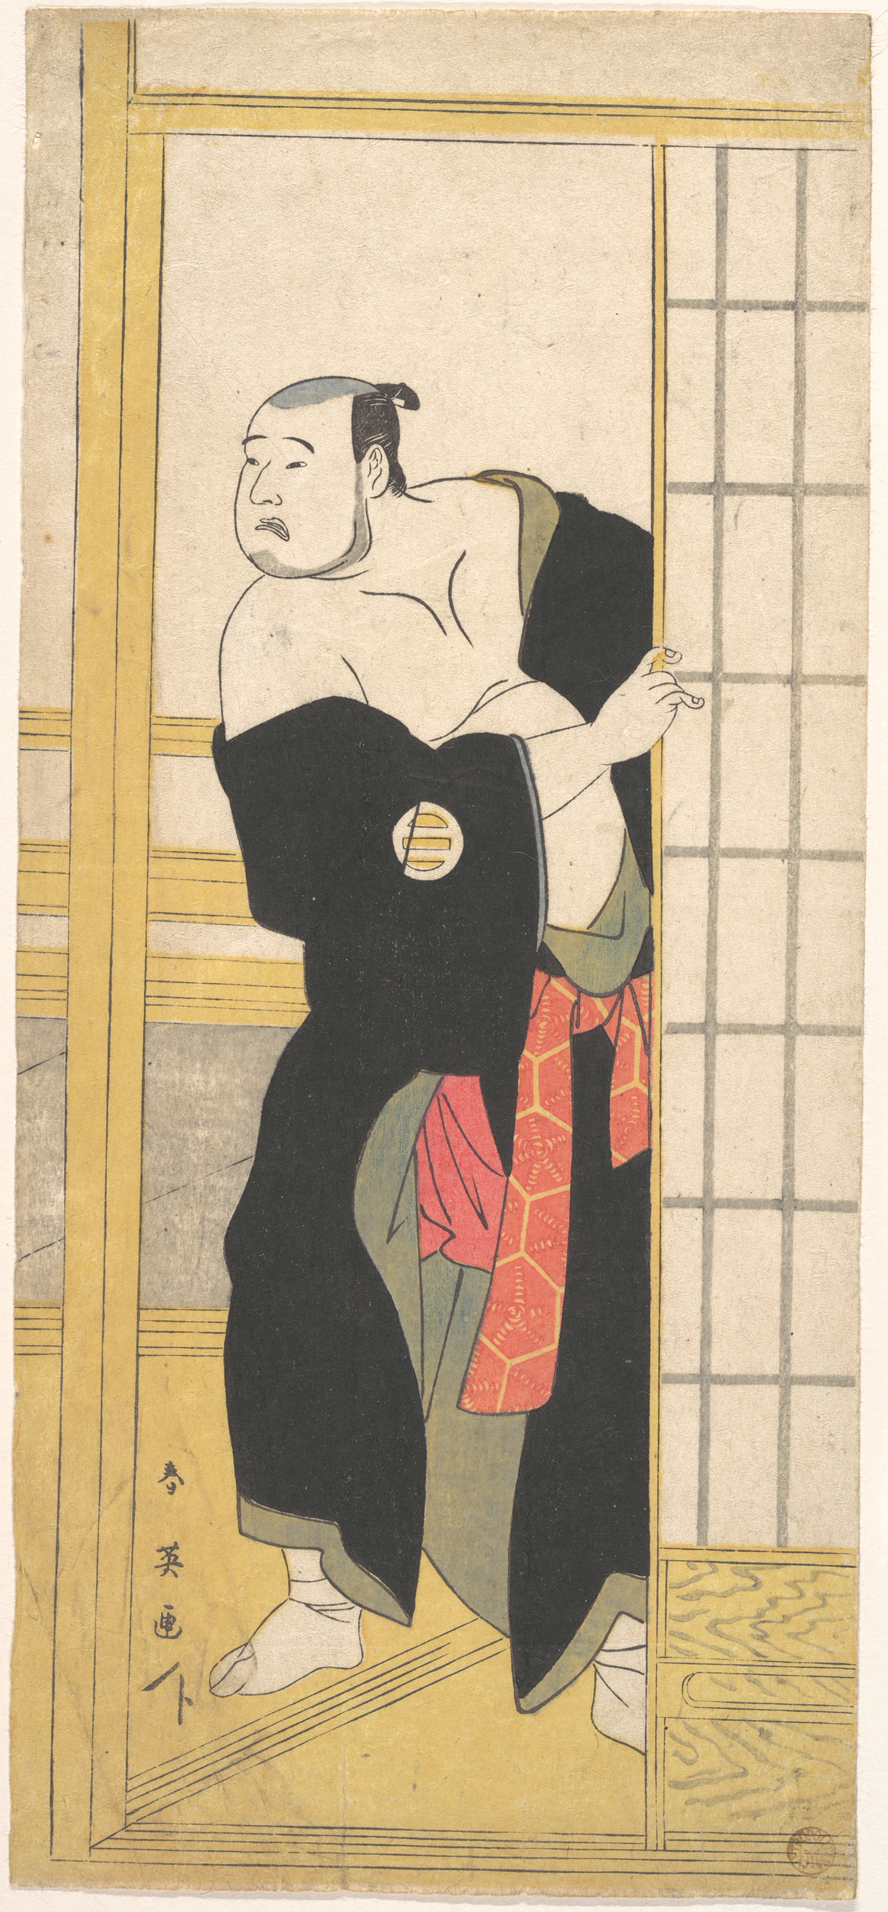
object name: print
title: Asao Tamesaburo as a Stout Man with a Green Kimono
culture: japanese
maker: katsukawa shun'ei 勝川春英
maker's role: artist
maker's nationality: japanese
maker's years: 1762-1819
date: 1795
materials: ink, paper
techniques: woodblock print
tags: men